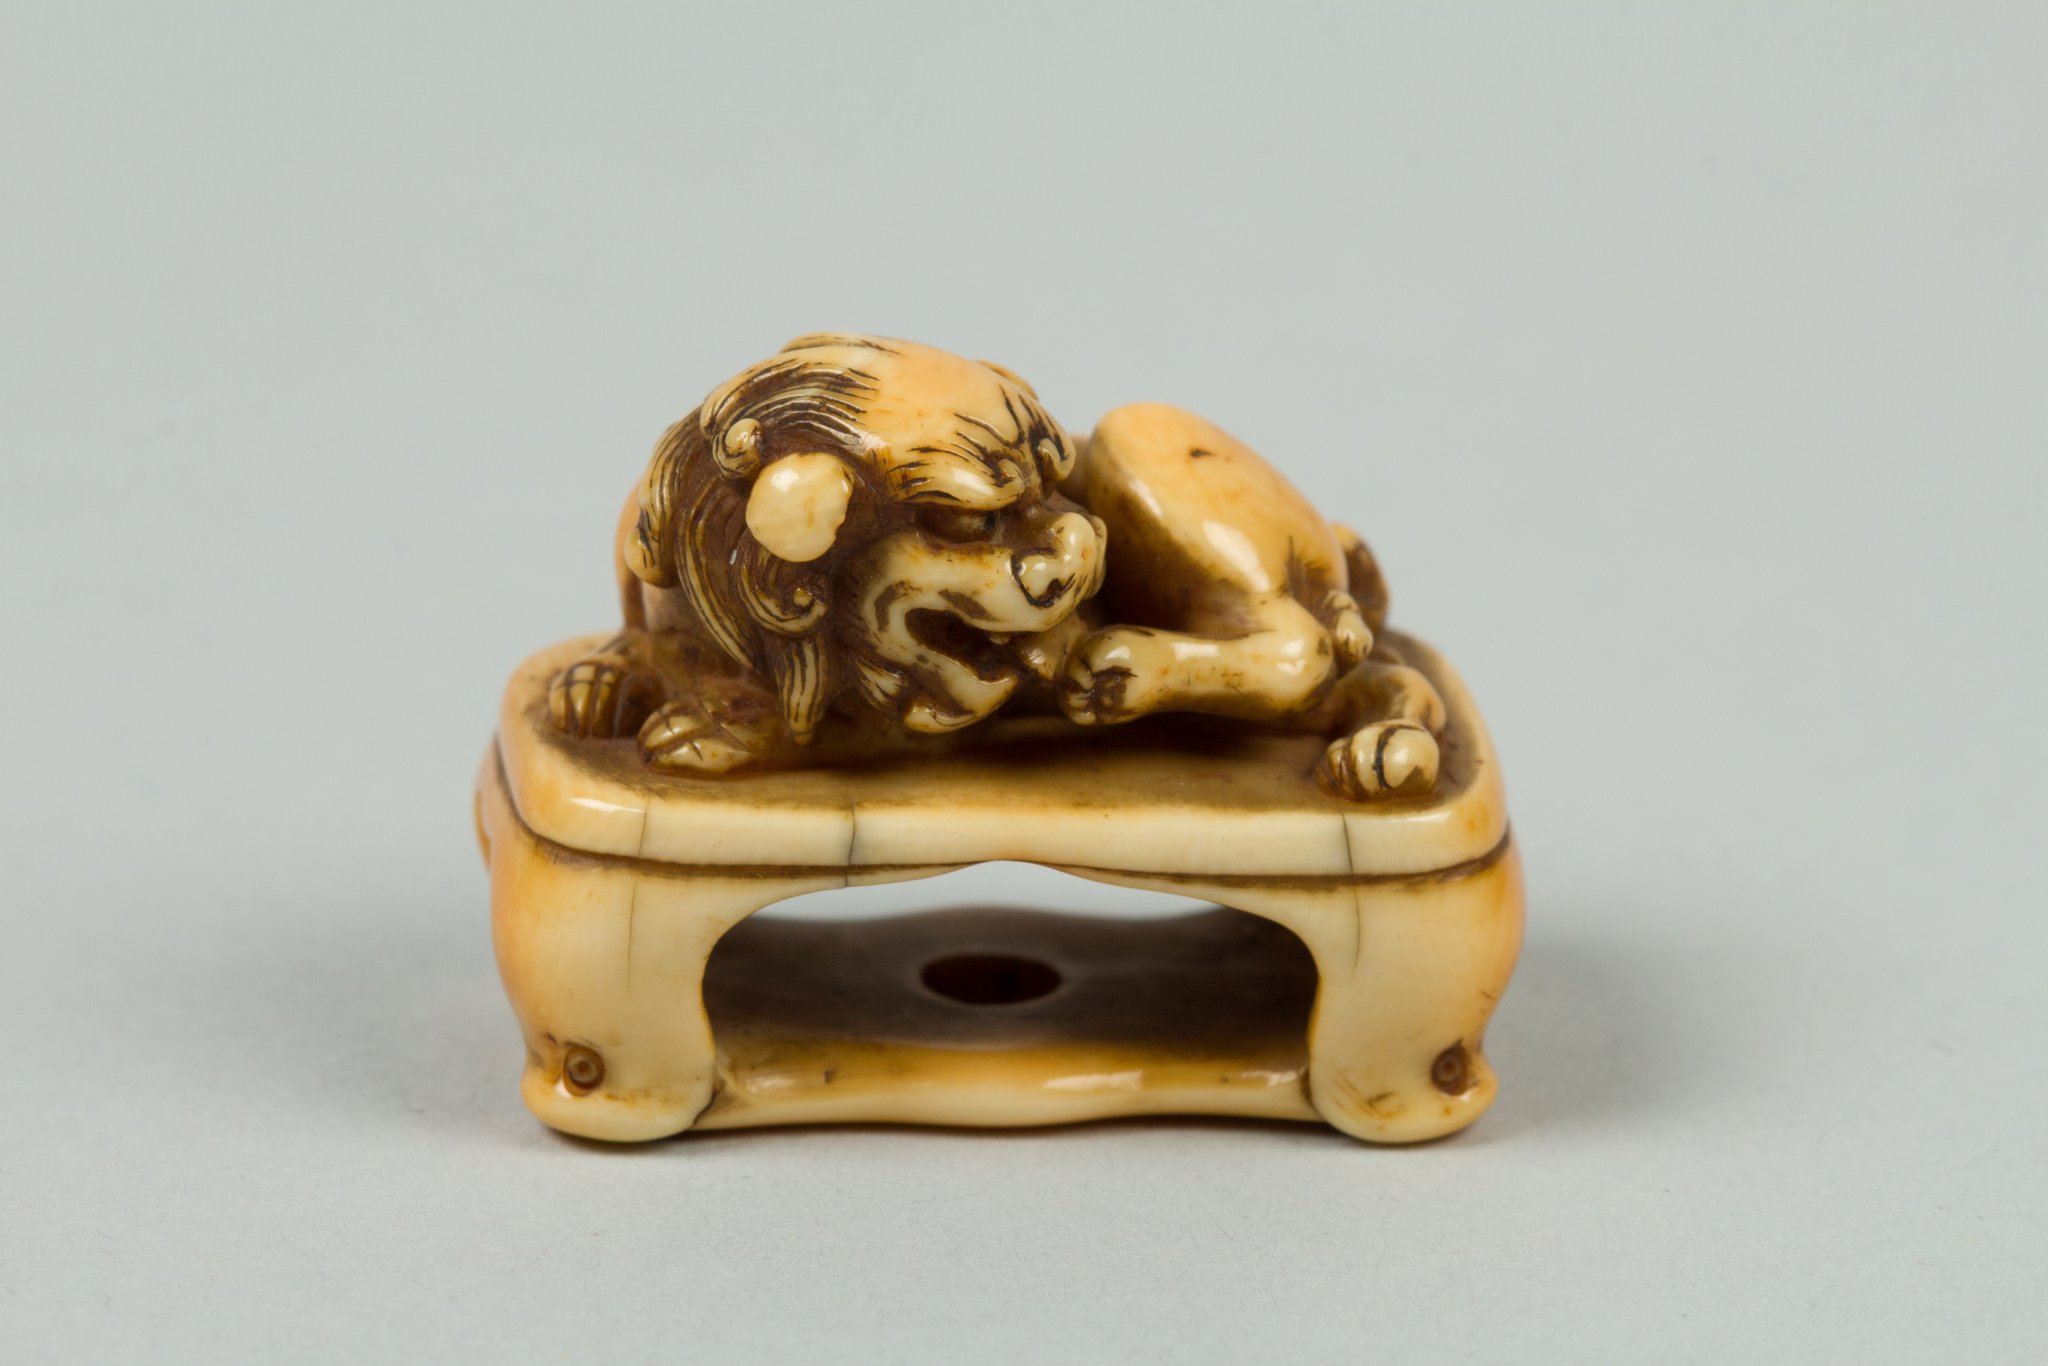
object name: netsuke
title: Netsuke of Lion on a Stand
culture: japanese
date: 1801-1900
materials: ivory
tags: lions